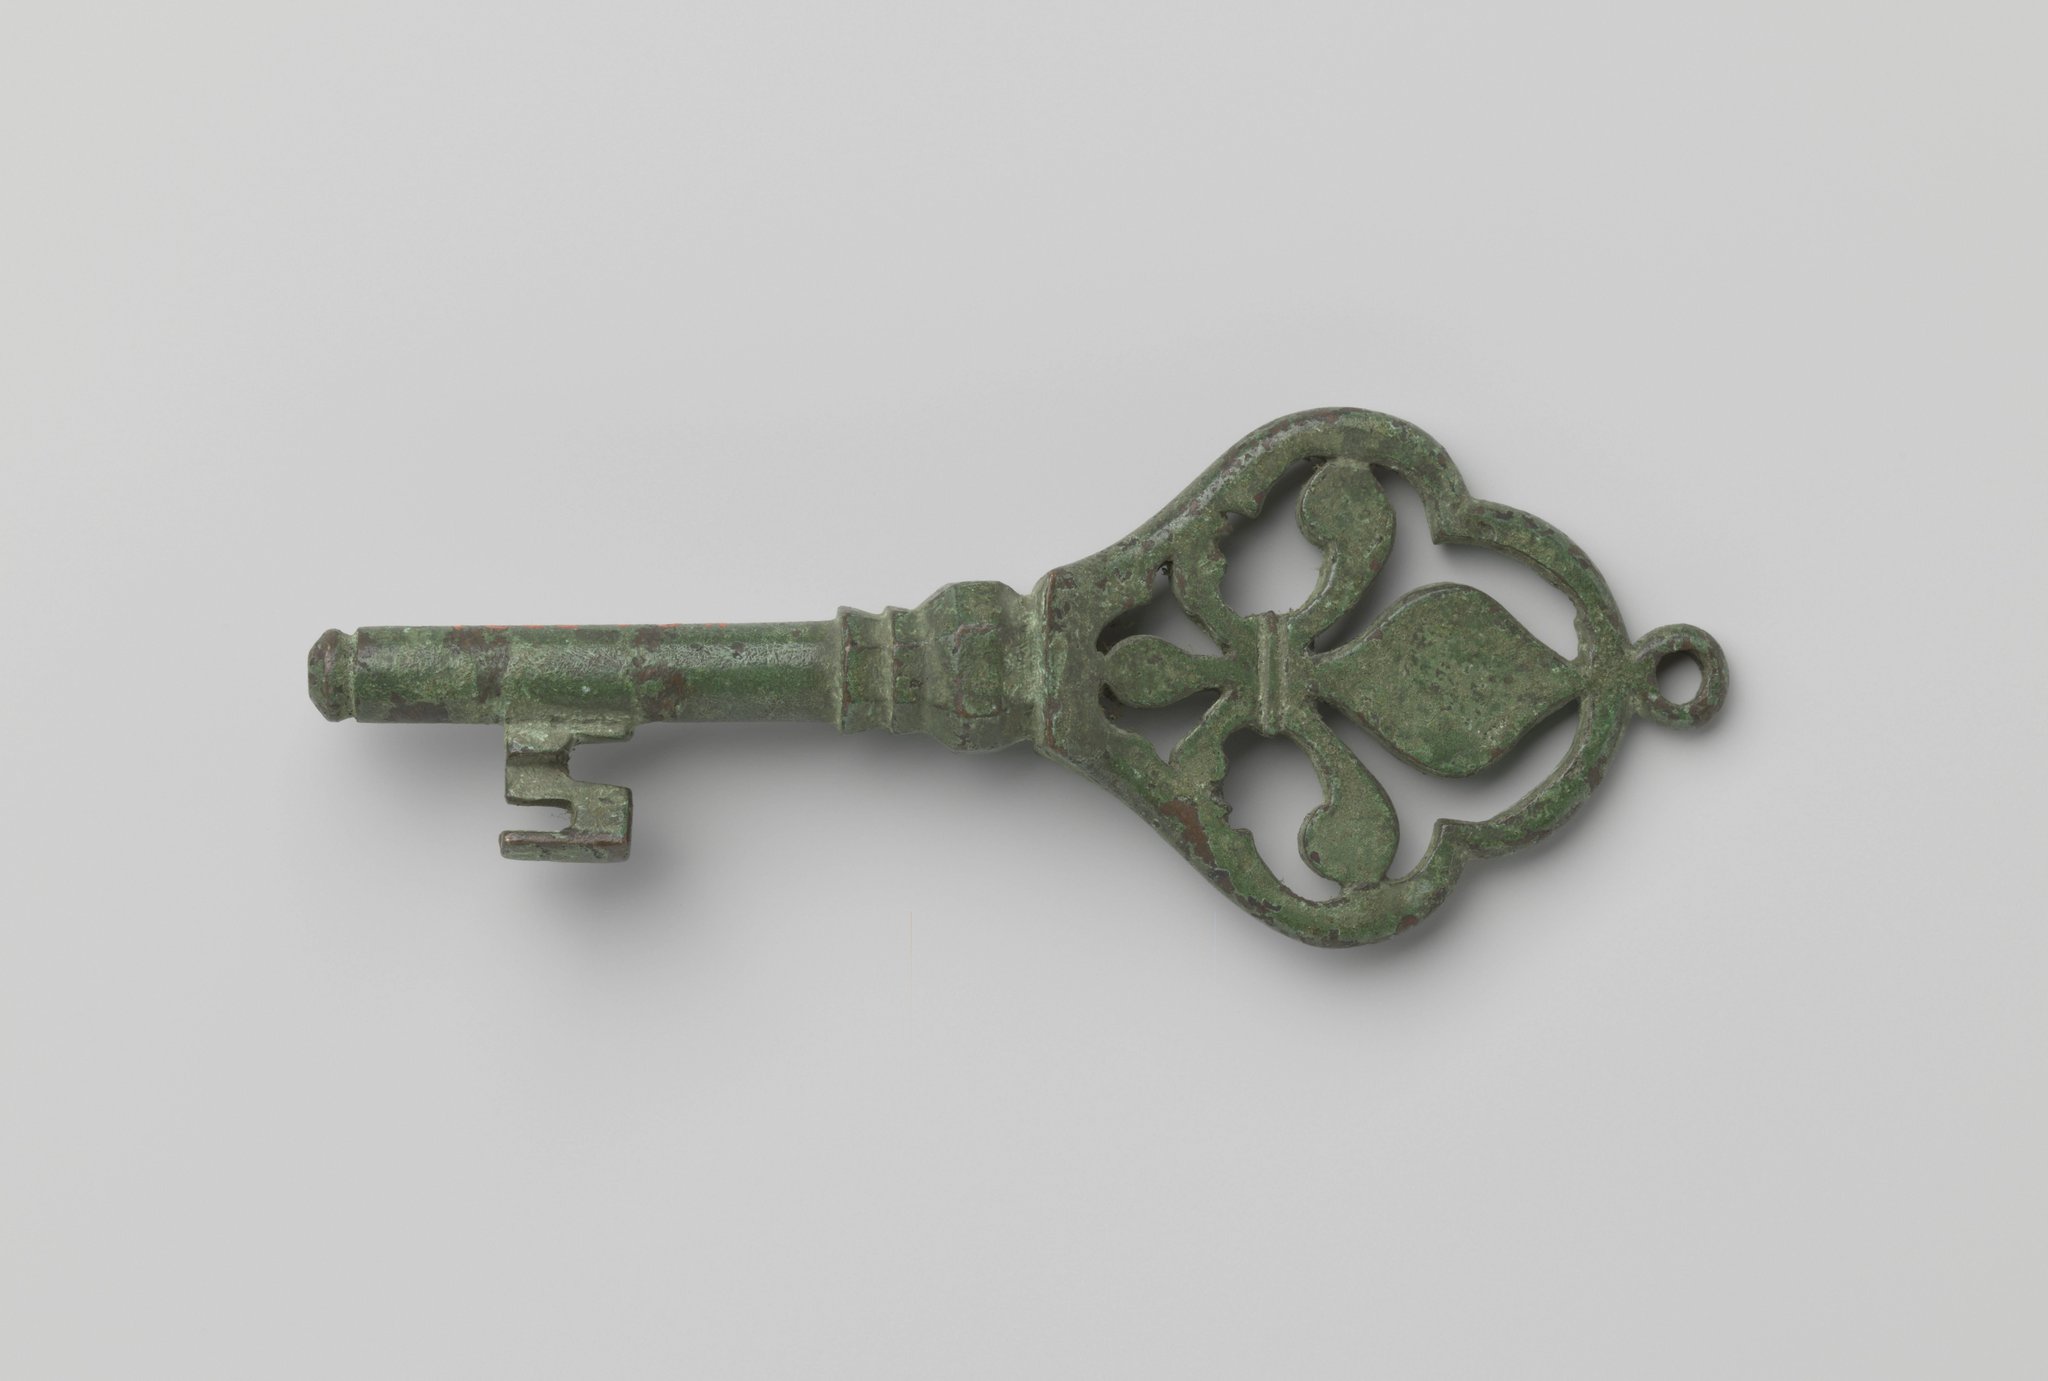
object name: key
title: Sleutel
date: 1600-1699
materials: bronze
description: Sleutel met driepasvormige greep, gevuld met de Franse lelie en bekroond door een oogje. Hieronder bevindt zich het geprofileerd achtzijdig kapiteel en de korte schacht die voorbij de kleine baard doorloopt en in een knopje eindigt.